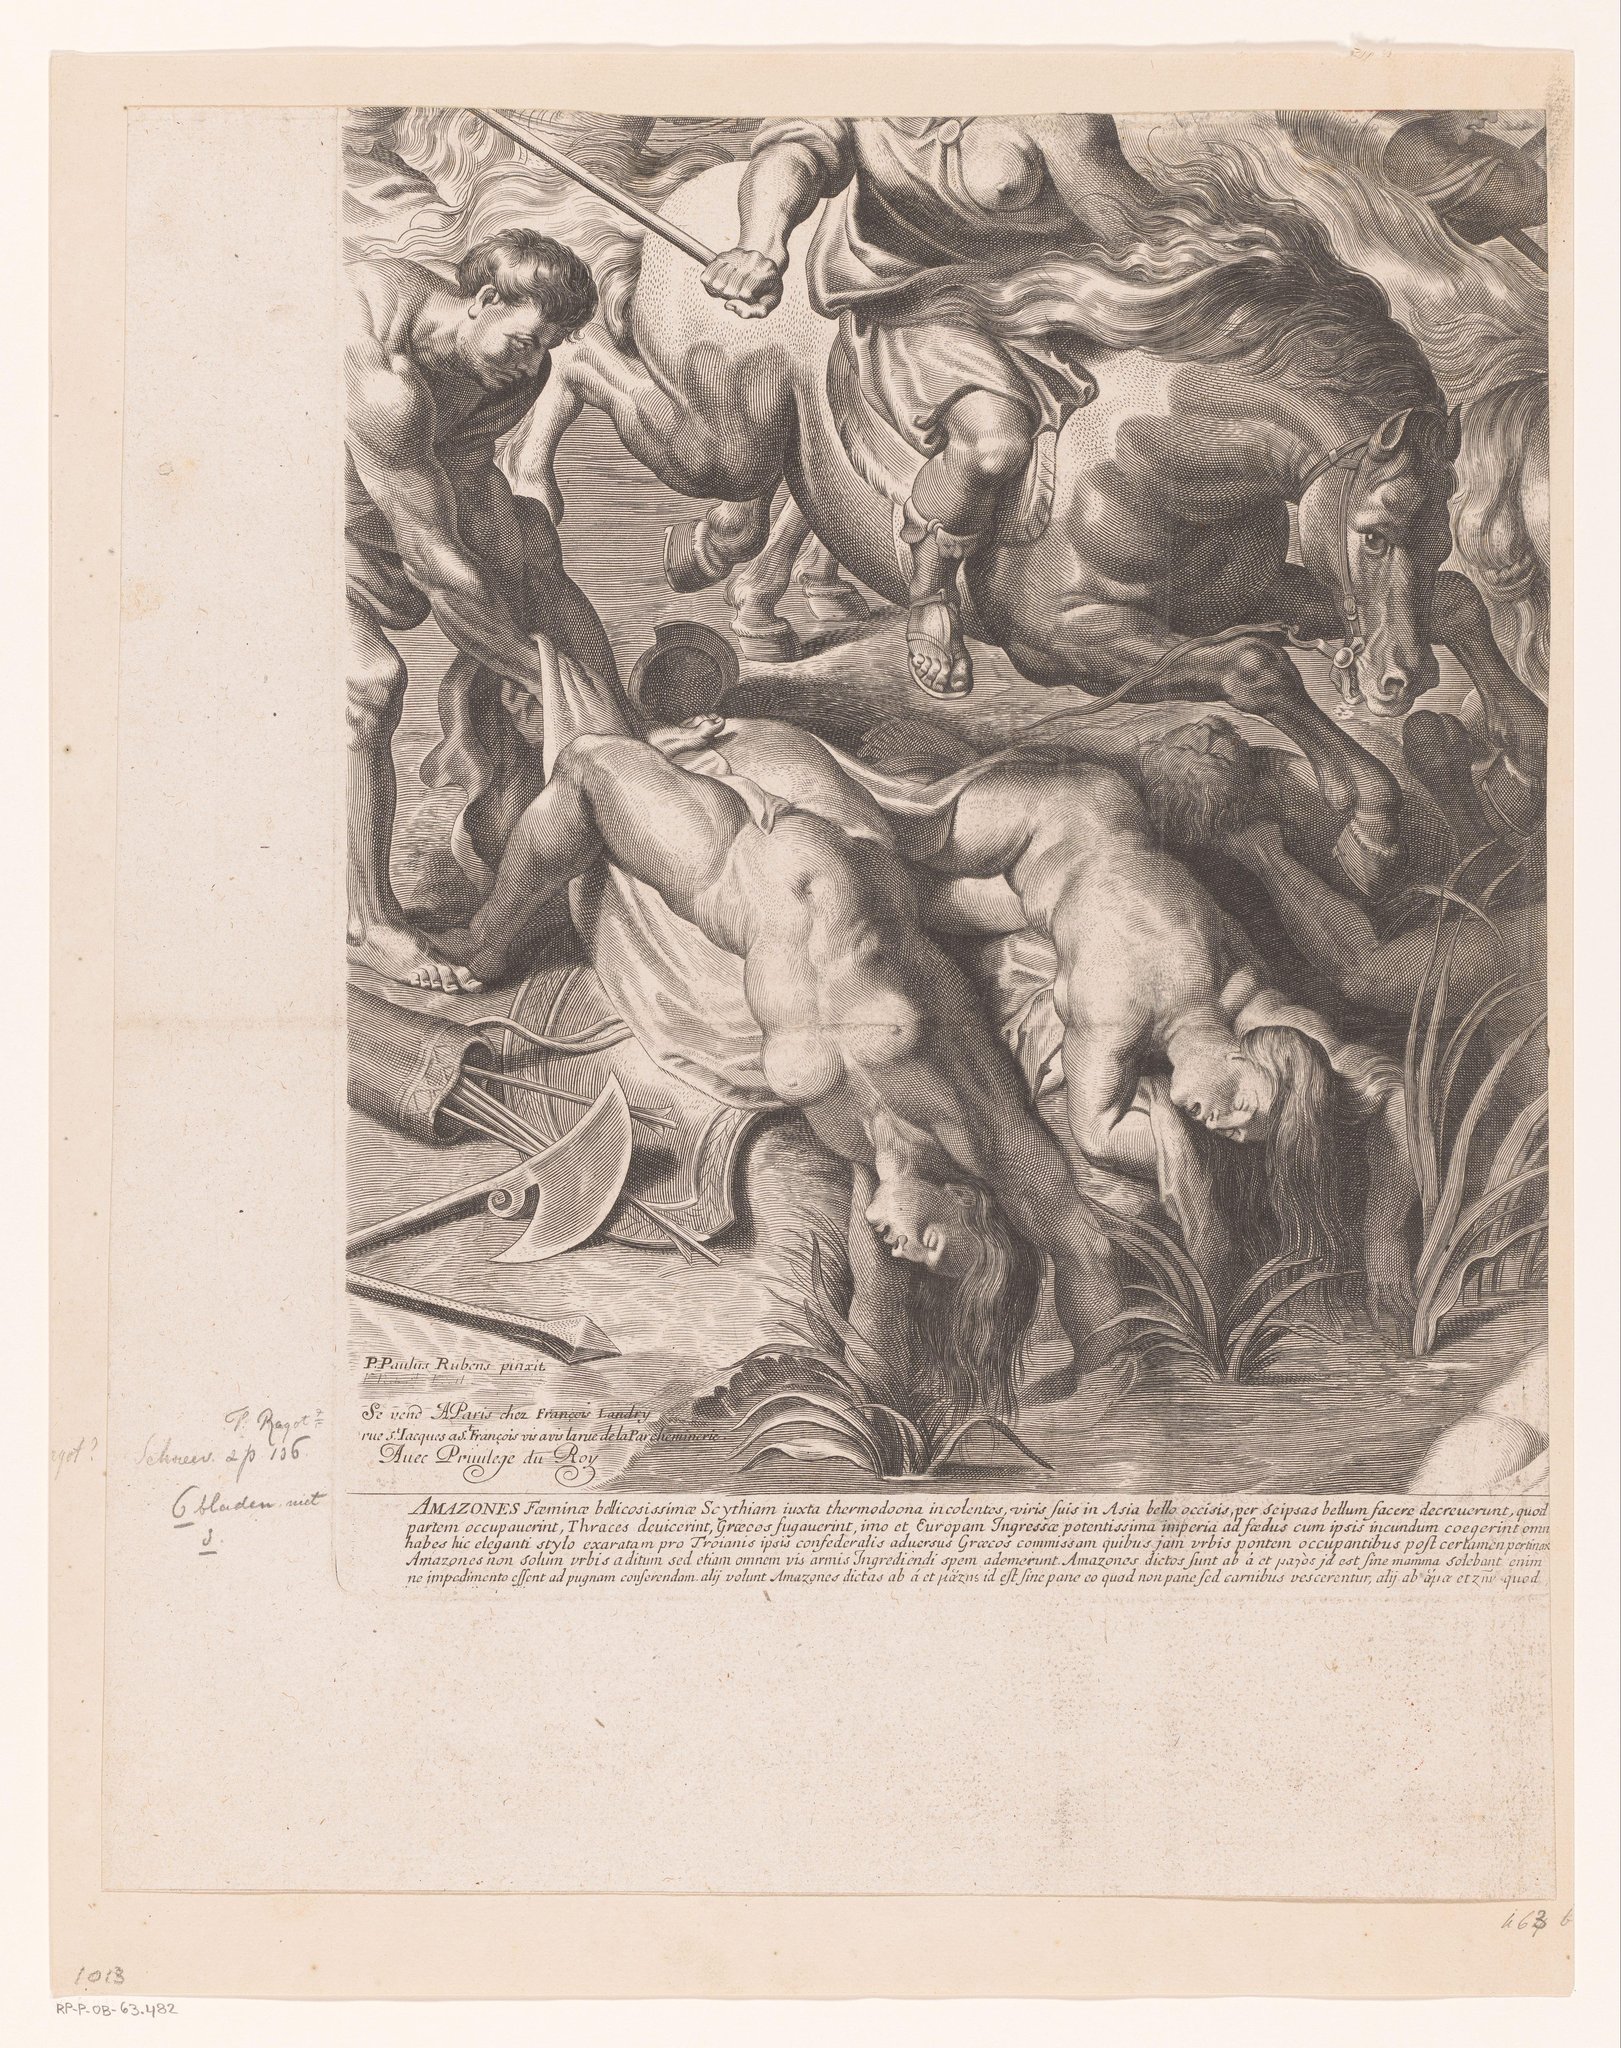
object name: print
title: Gevecht tussen Amazones en Grieken (deel linksonder)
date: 1648-1670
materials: paper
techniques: engraving, etching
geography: paris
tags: battle of amazons; amazonomachy, bridge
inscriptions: collector's mark: Lugt 240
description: Gevecht tussen Amazones en Grieken op de brug van Troje.